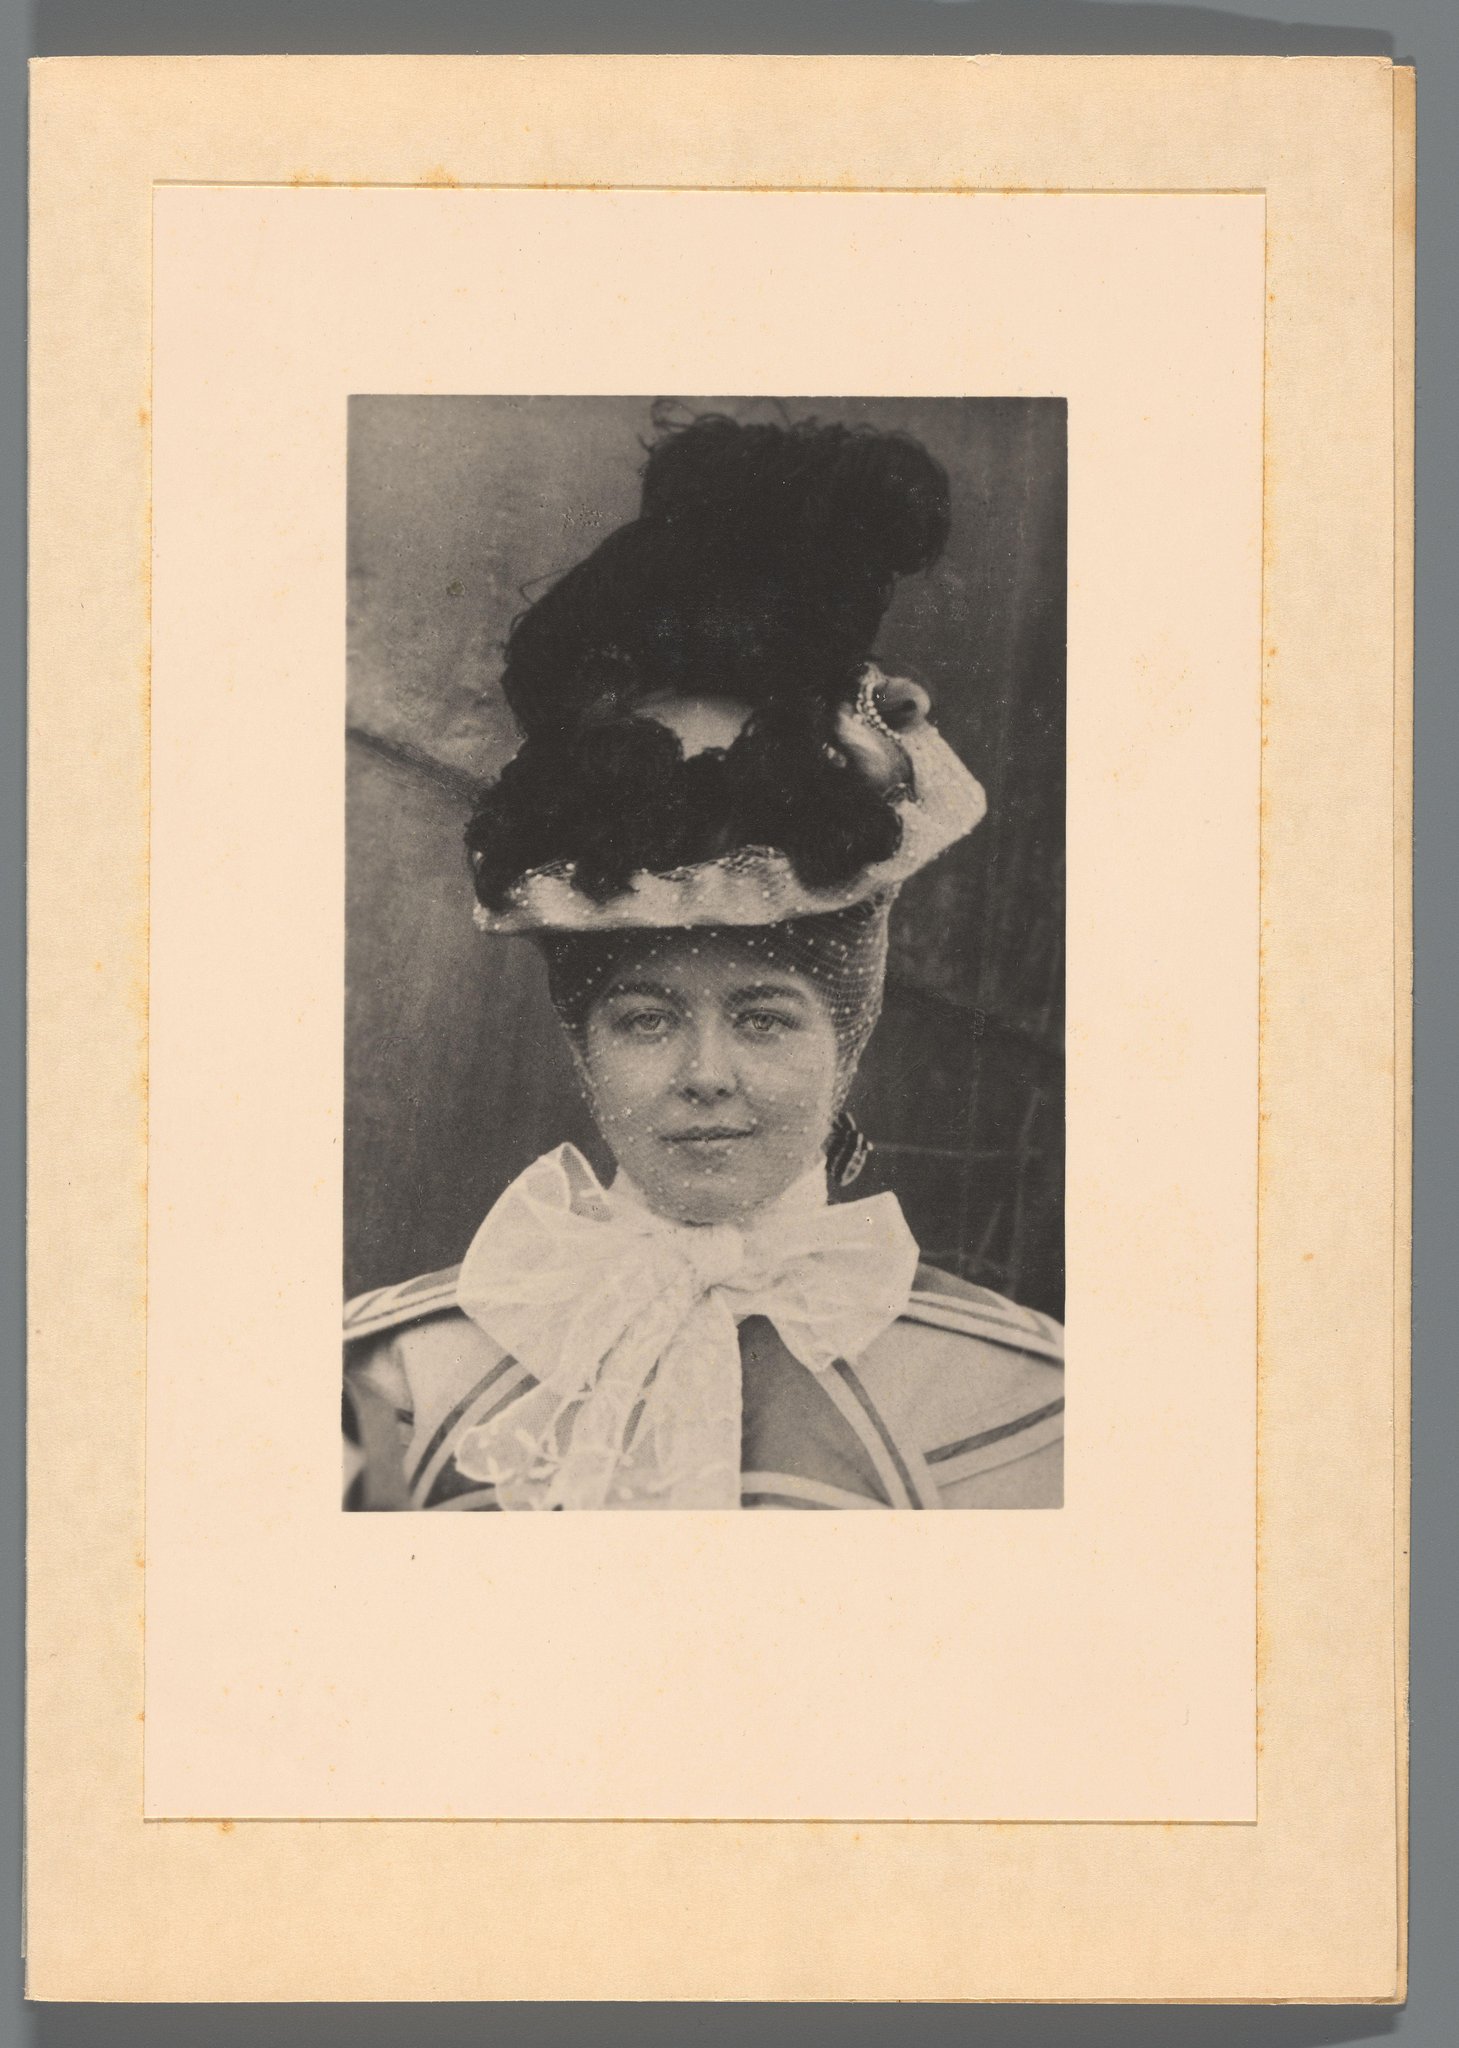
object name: photograph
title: Portret van A.C.M. Geertsema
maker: Anonymous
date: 1880-1910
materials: cardboard, photographic support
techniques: photography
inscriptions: name: ‘Kameke’, name: ‘Kameke’